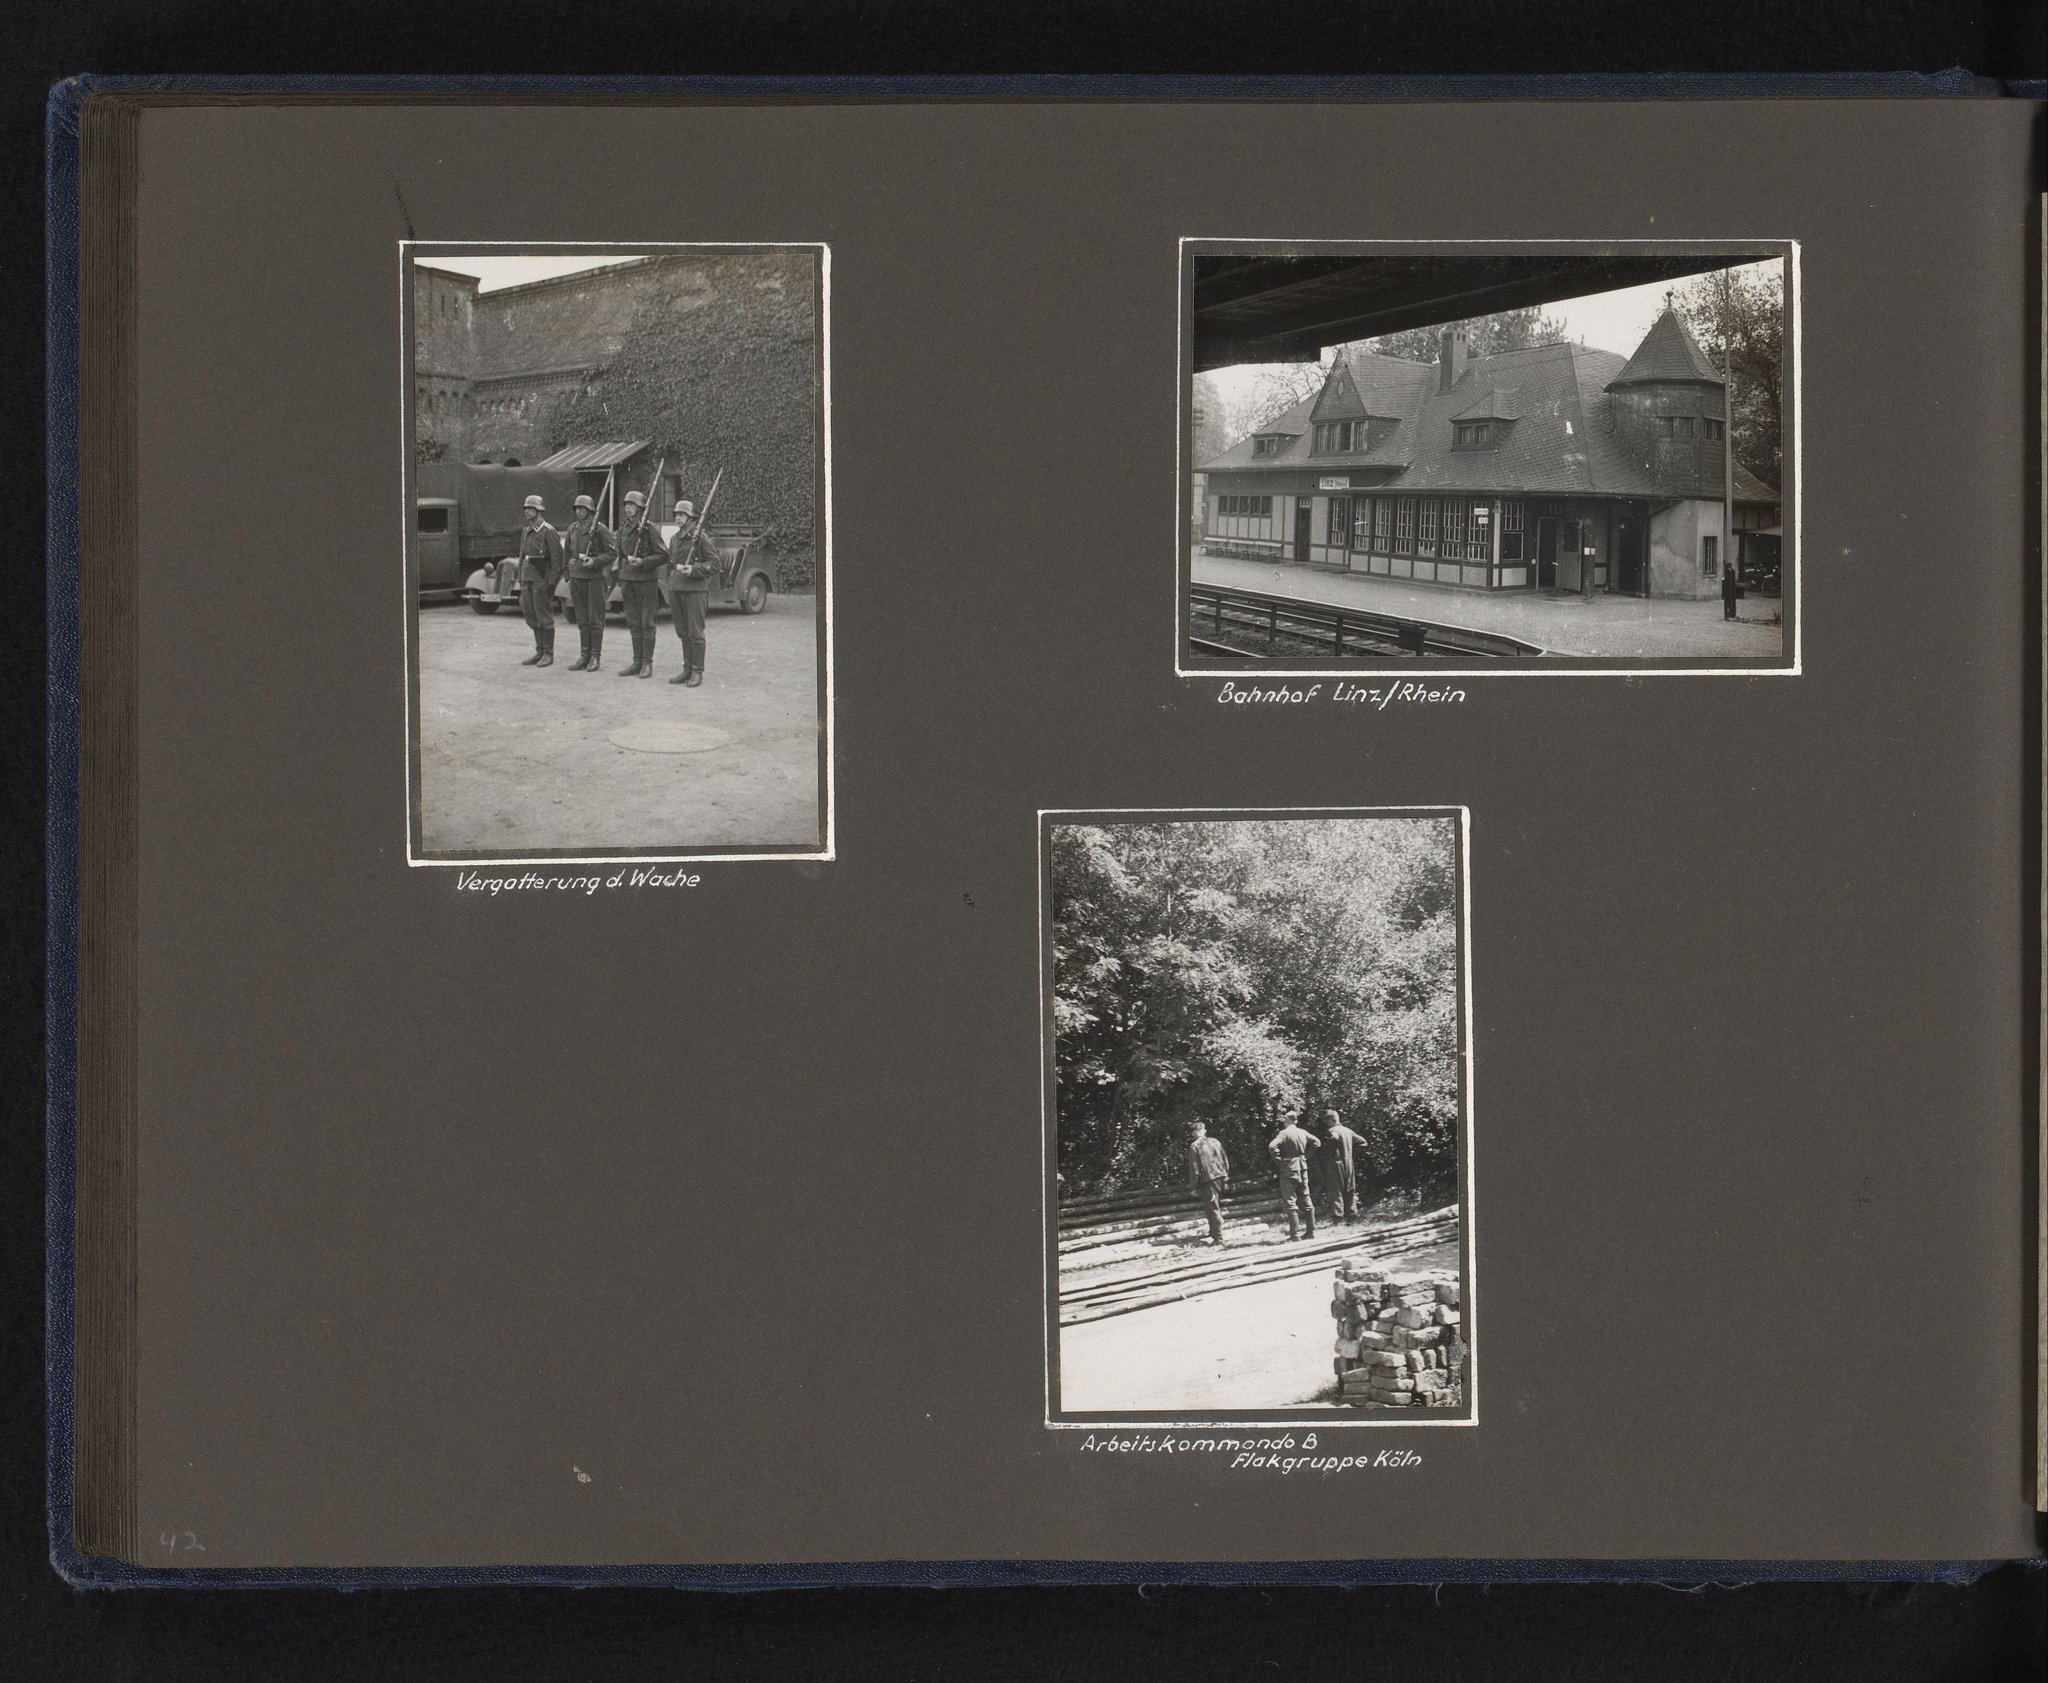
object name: photograph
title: Op wacht en 'Arbeitskommando'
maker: Anonymous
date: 1940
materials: paper, photographic support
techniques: gelatin silver print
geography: germany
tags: the company, the unit, the troop ~ military service, station; shelter (railway, tramway), guard duty, keeping sentry, germany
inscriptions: inscription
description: Albumblad met drie foto's van Duitse militairen op wacht, bezig met arbeidsdienst en het treinstation van Linz am Rhein, 1940. Onderdeel van een Duits militair album Tweede Wereldoorlog 1939-1940.